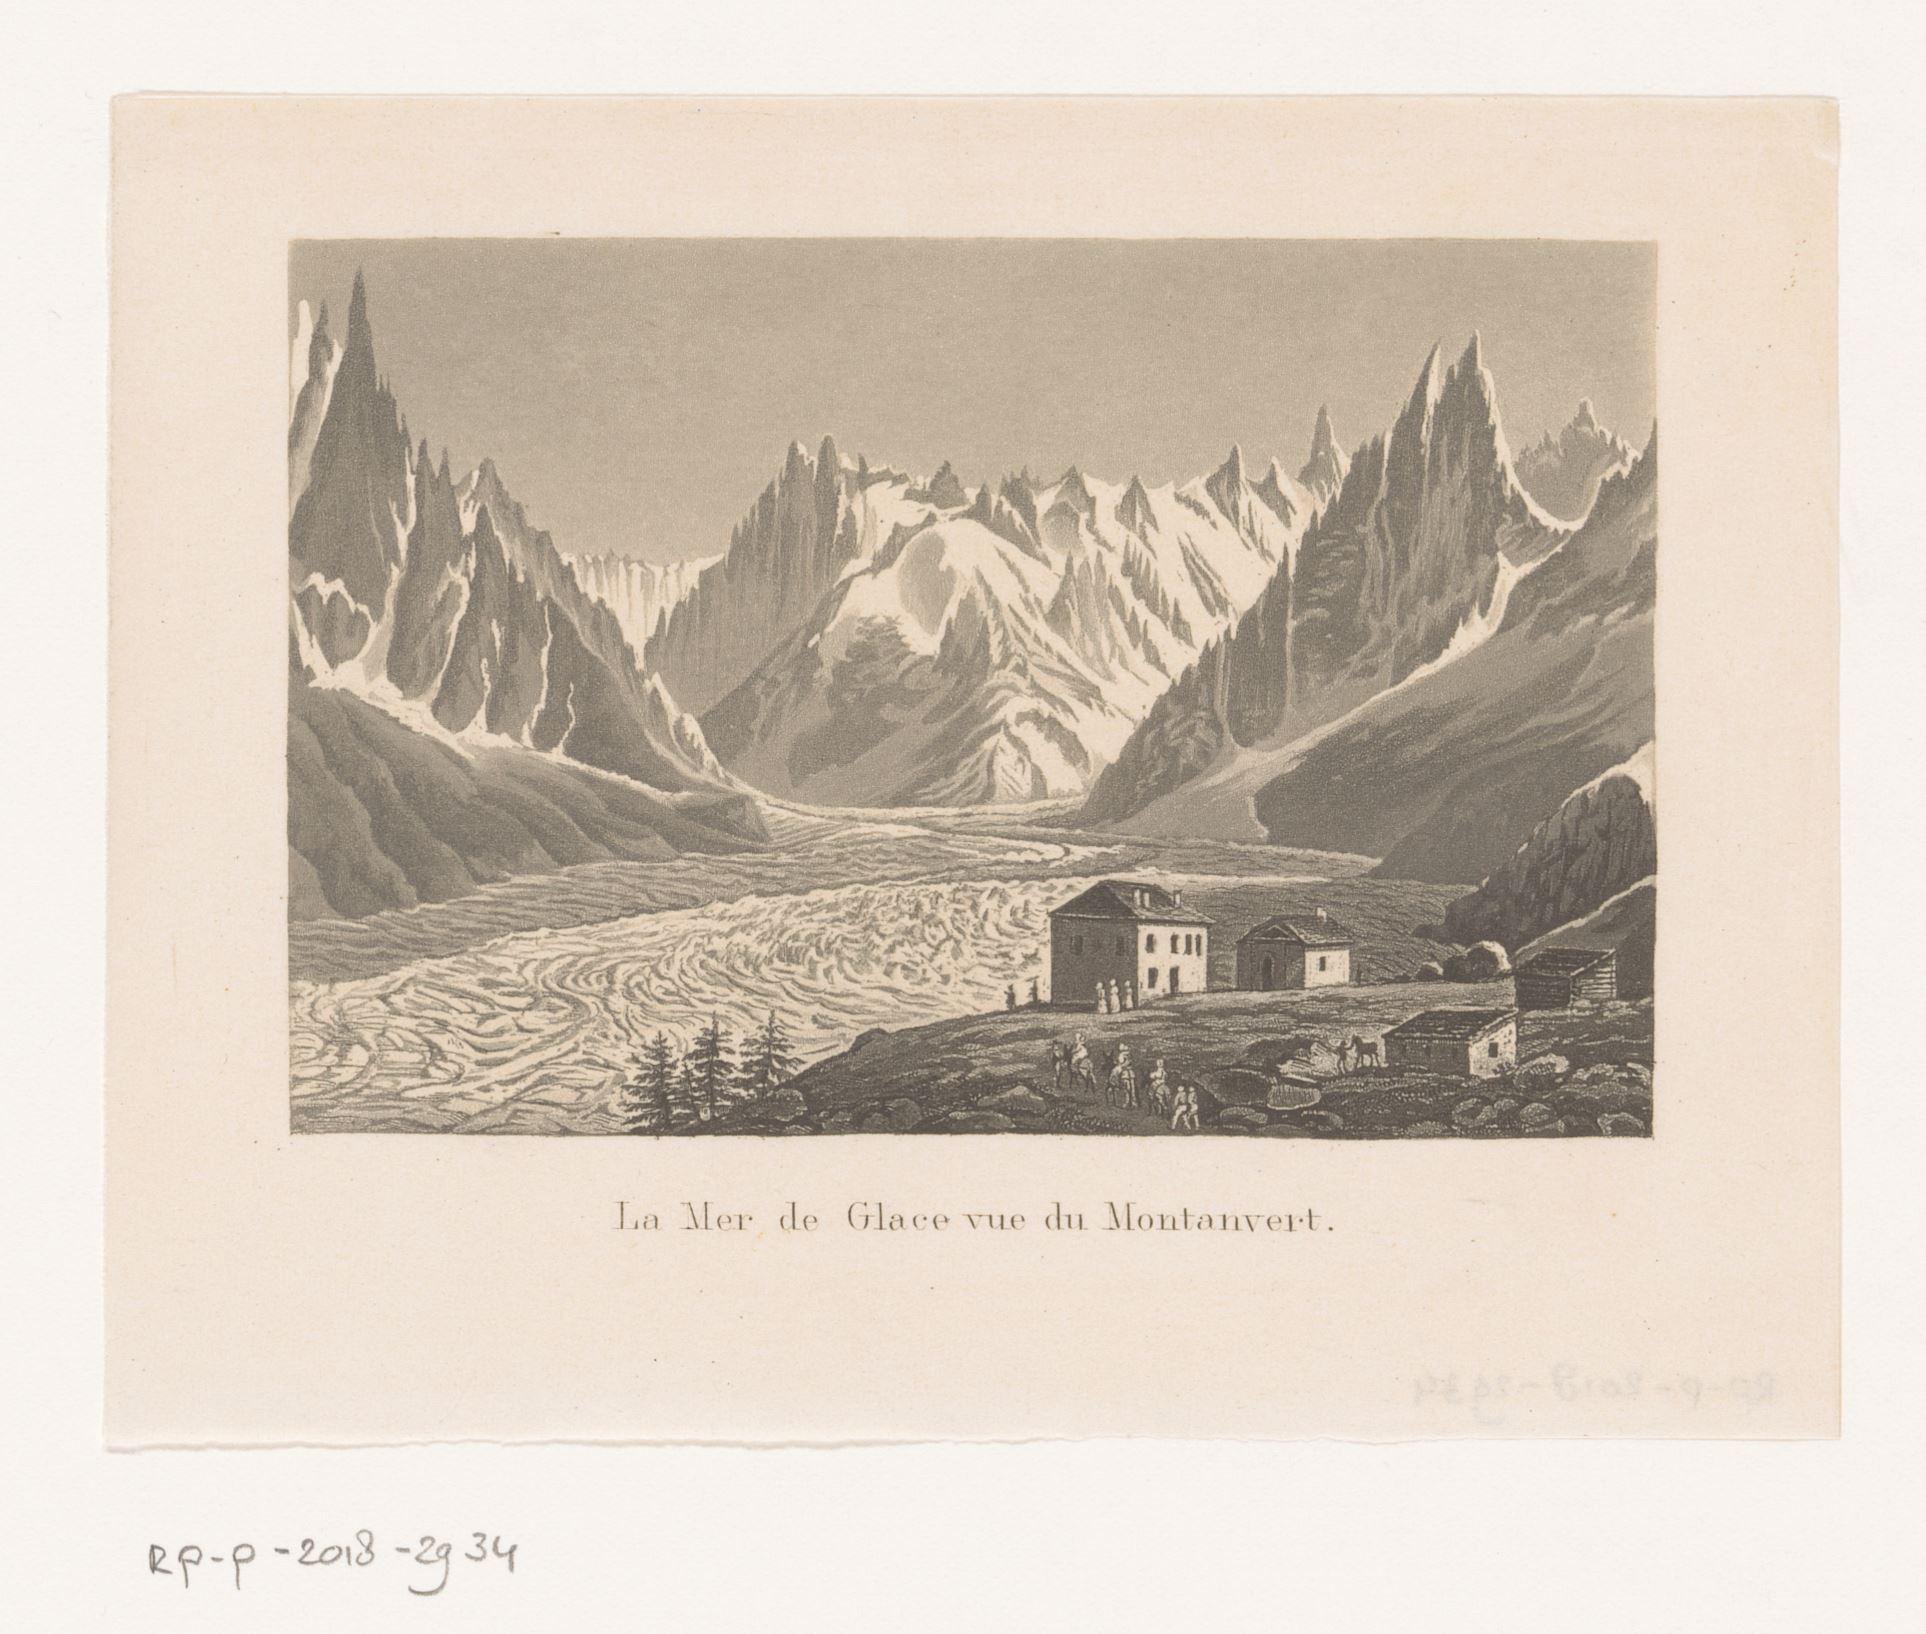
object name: print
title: La Mer de Glace vue du Montanvert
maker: Anonymous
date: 1750-1850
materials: paper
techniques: aquatint, etching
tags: glacier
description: Gezicht op de gletsjer Mer de Glace vanaf Montanvert.